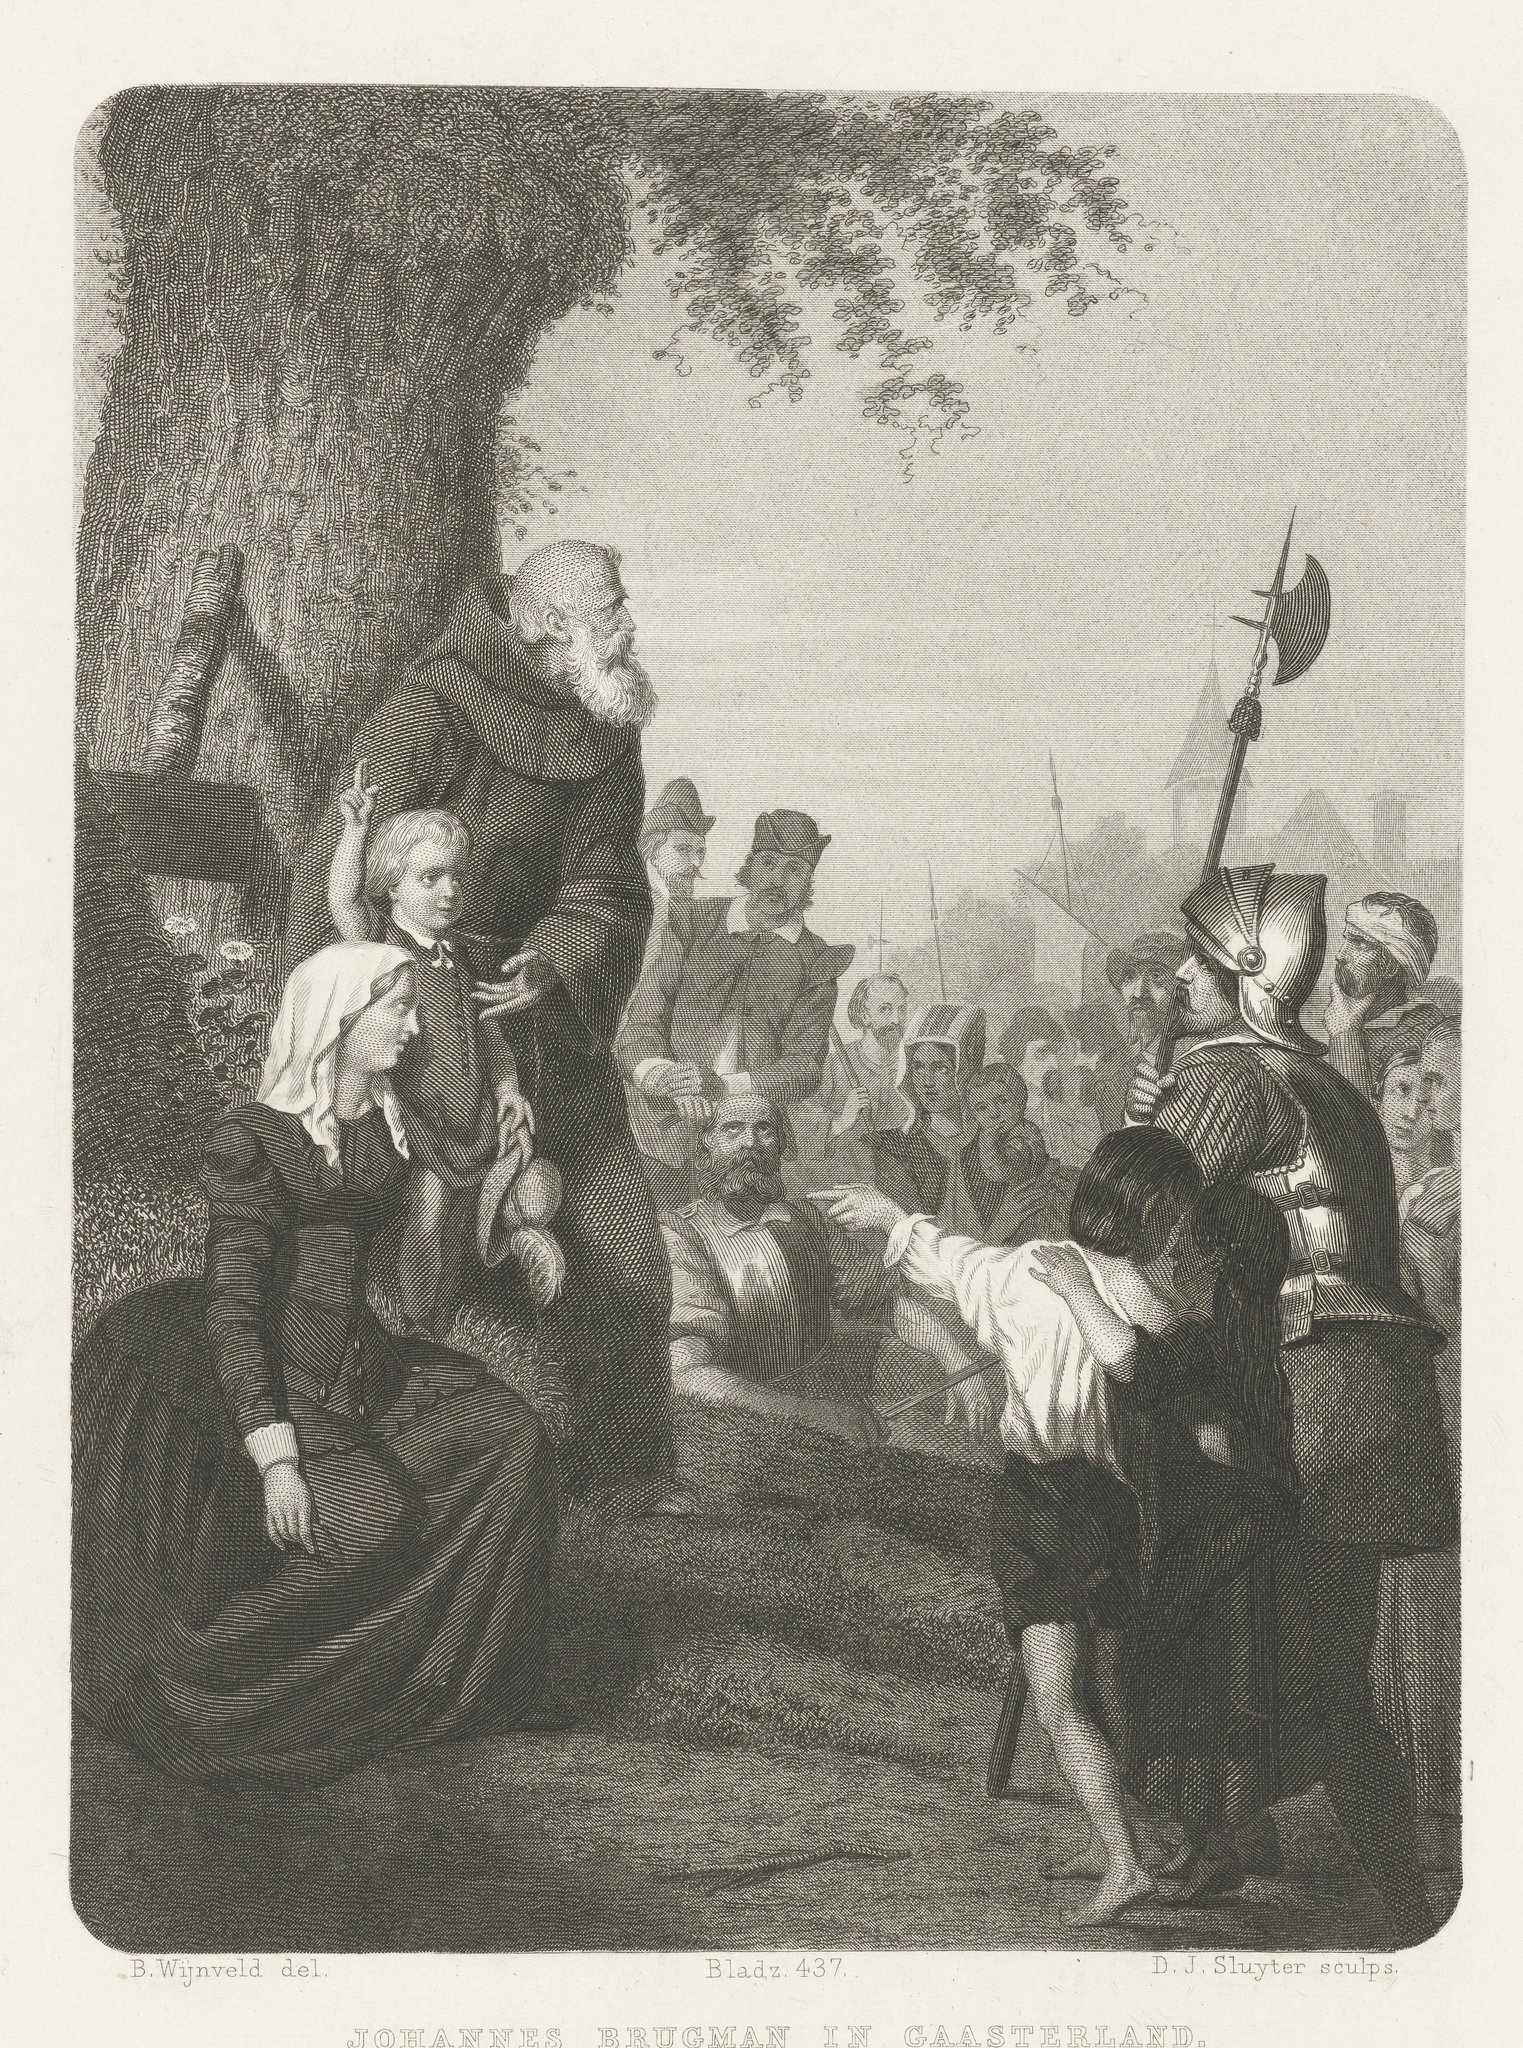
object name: history print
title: Johannes Brugman in Gaasterland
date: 1862-1864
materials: paper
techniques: engraving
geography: netherlands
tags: preaching (in general), burgundian netherlands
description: Illustratie voor: B. ter Haar en W. Moll, Geschiedenis der Christelijke Kerk in Nederland in tafereelen, 2 delen. Amsterdam 1864, dl. I, p. 437.